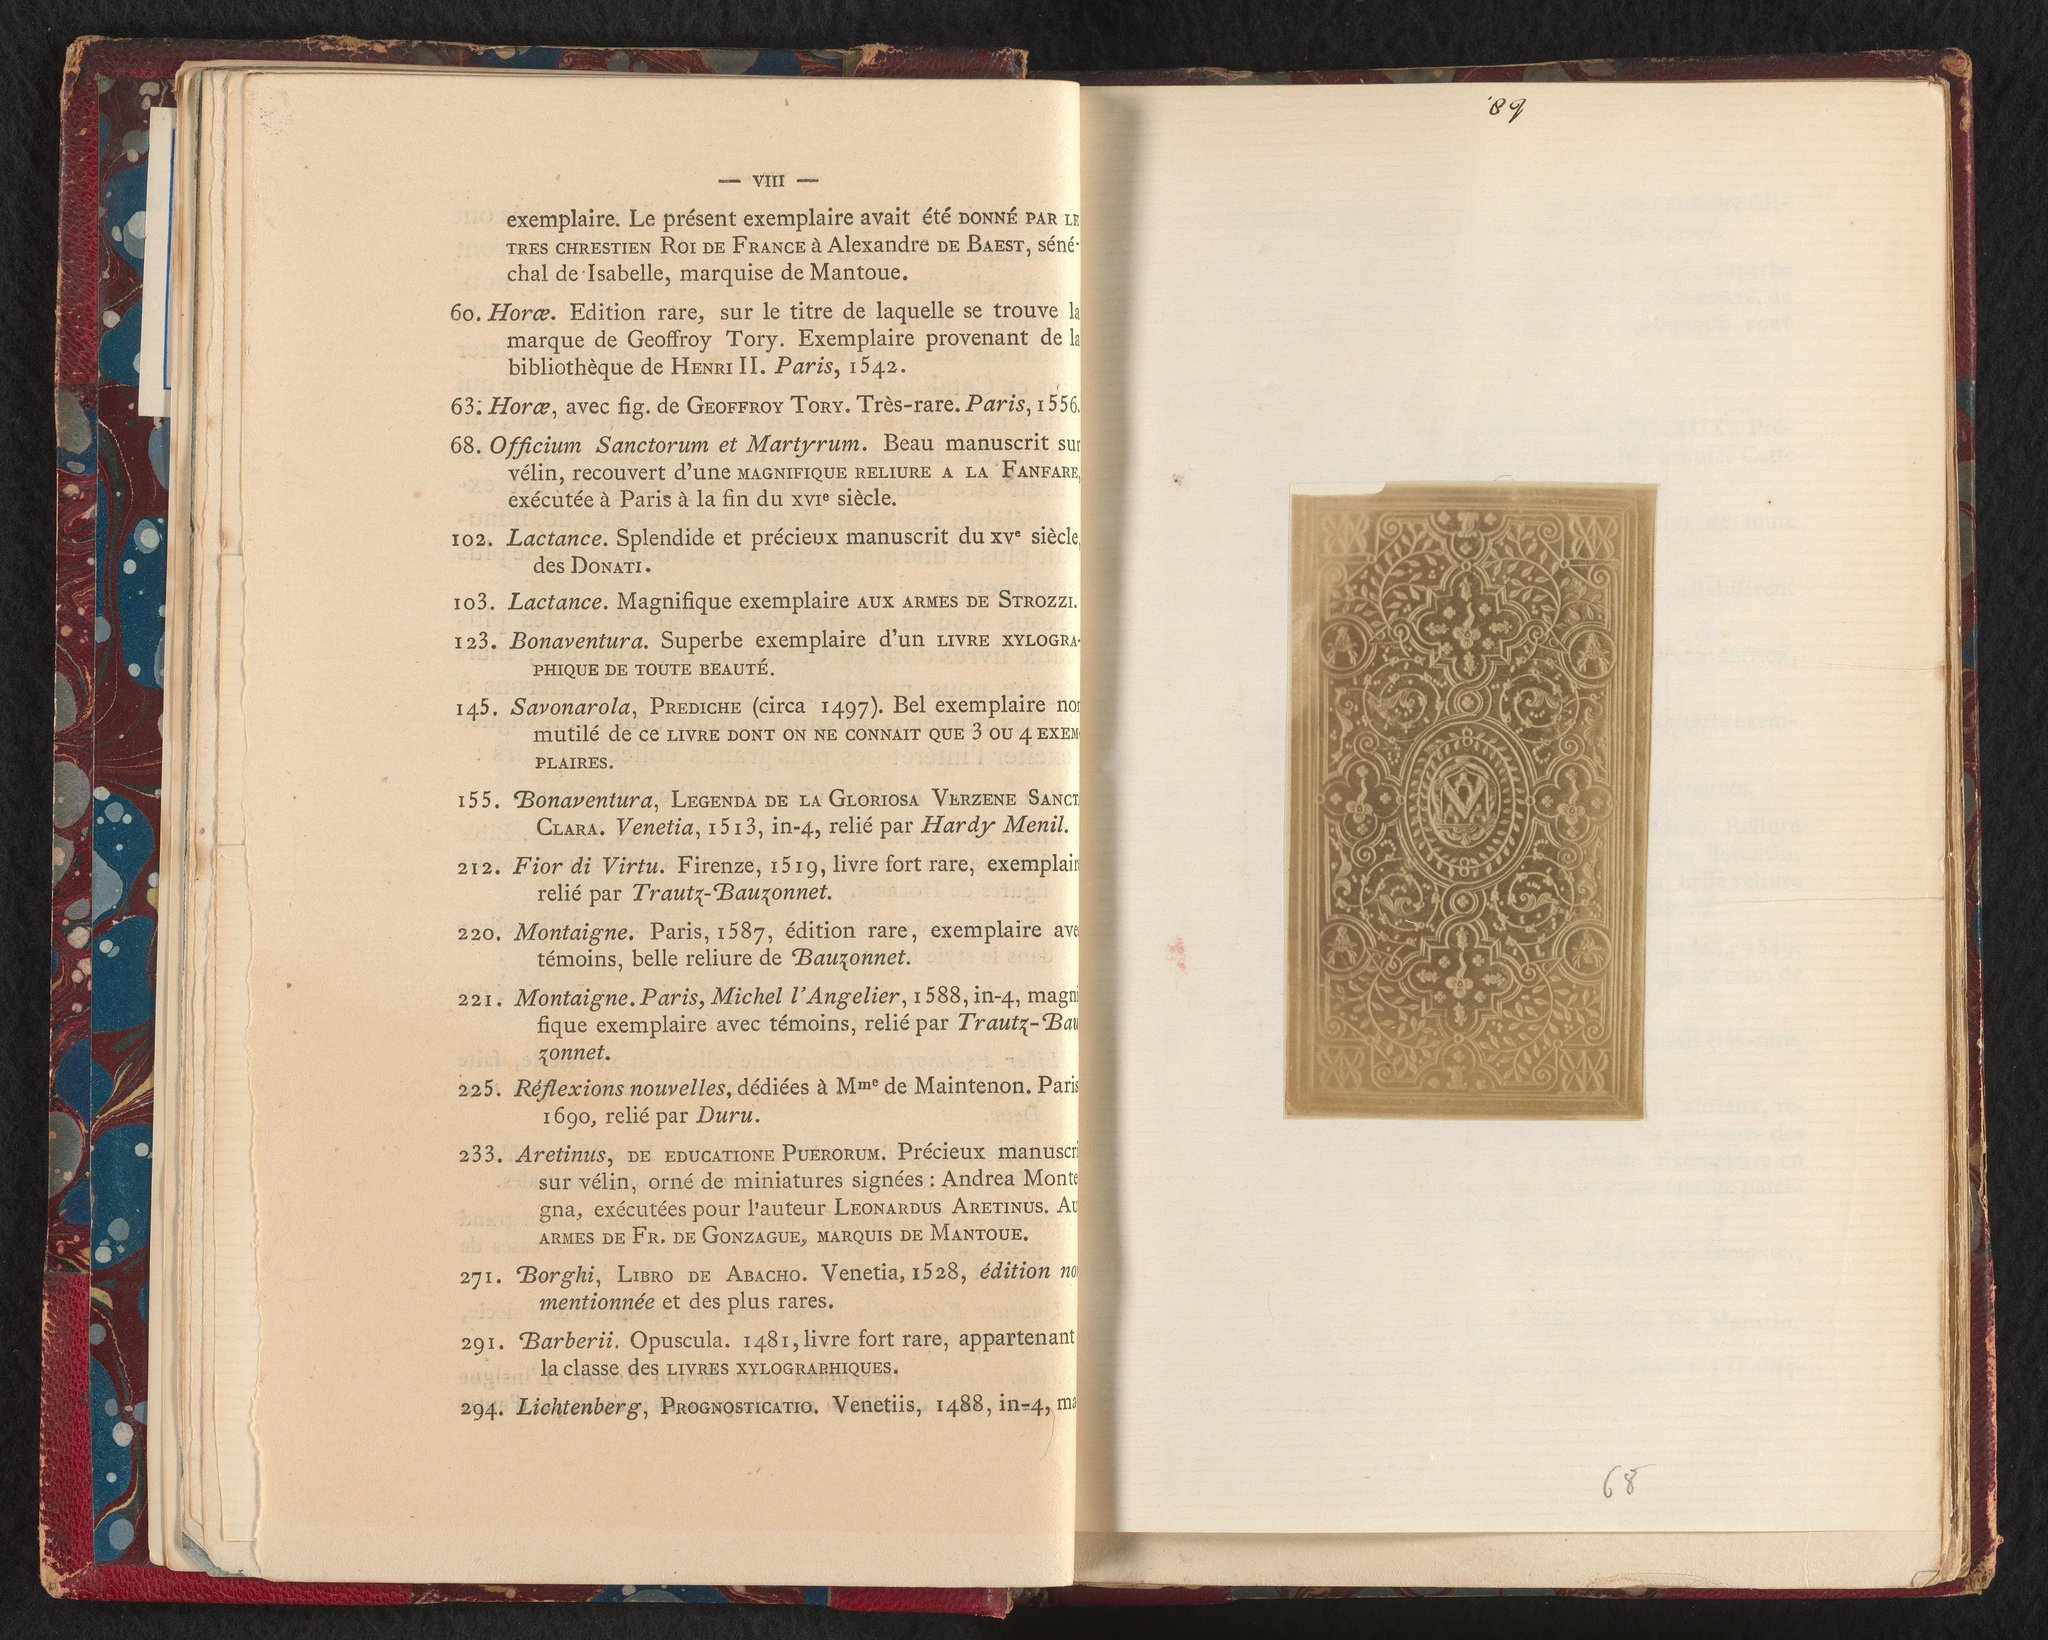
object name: reproduction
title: Fotoreproductie van boekomslag van Officium Sanctorum et Martyrum uit de zestiende eeuw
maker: Anonymous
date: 1863-1868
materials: paper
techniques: albumen print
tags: book-cover, binding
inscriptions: number: ‘68’